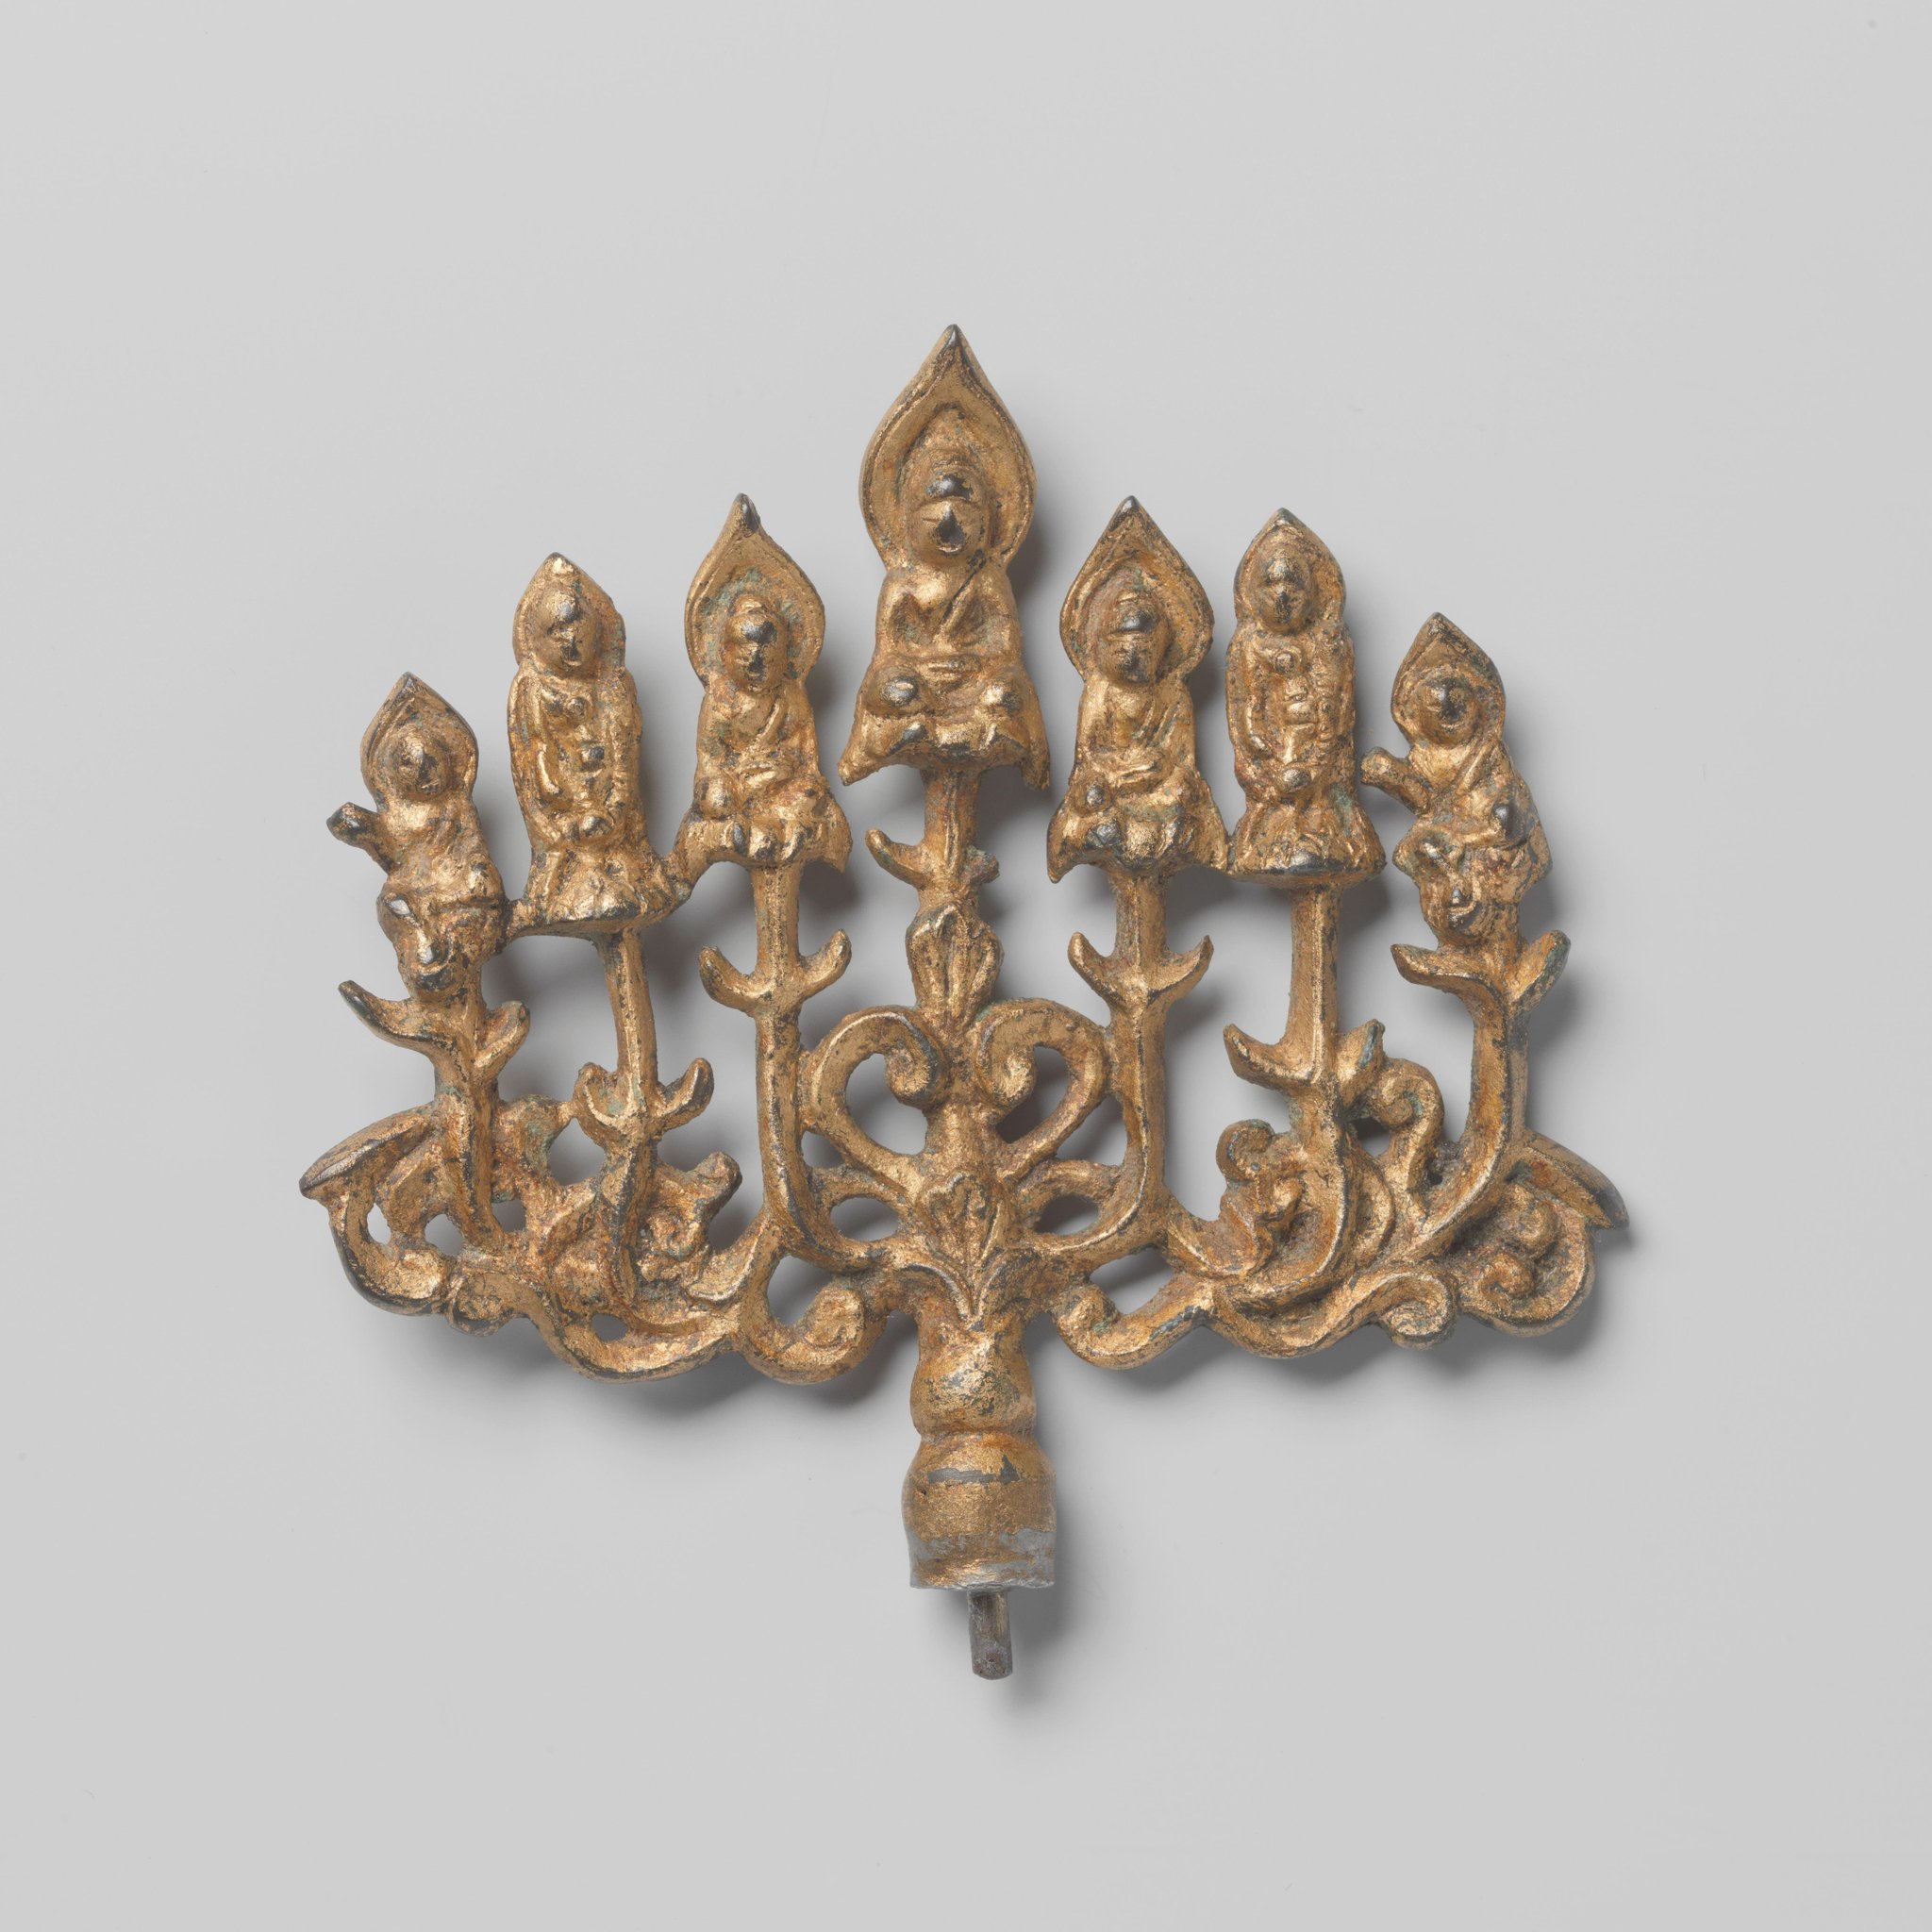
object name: sculpture group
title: Beeldengroep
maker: Anonymous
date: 618-907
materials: bronze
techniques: gilding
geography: china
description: Voetstuk bij de zeven Boeddha's van het Verleden, rustend op de uiteinden van gestileerde ranken. Mogelijk is dit een vervalsing